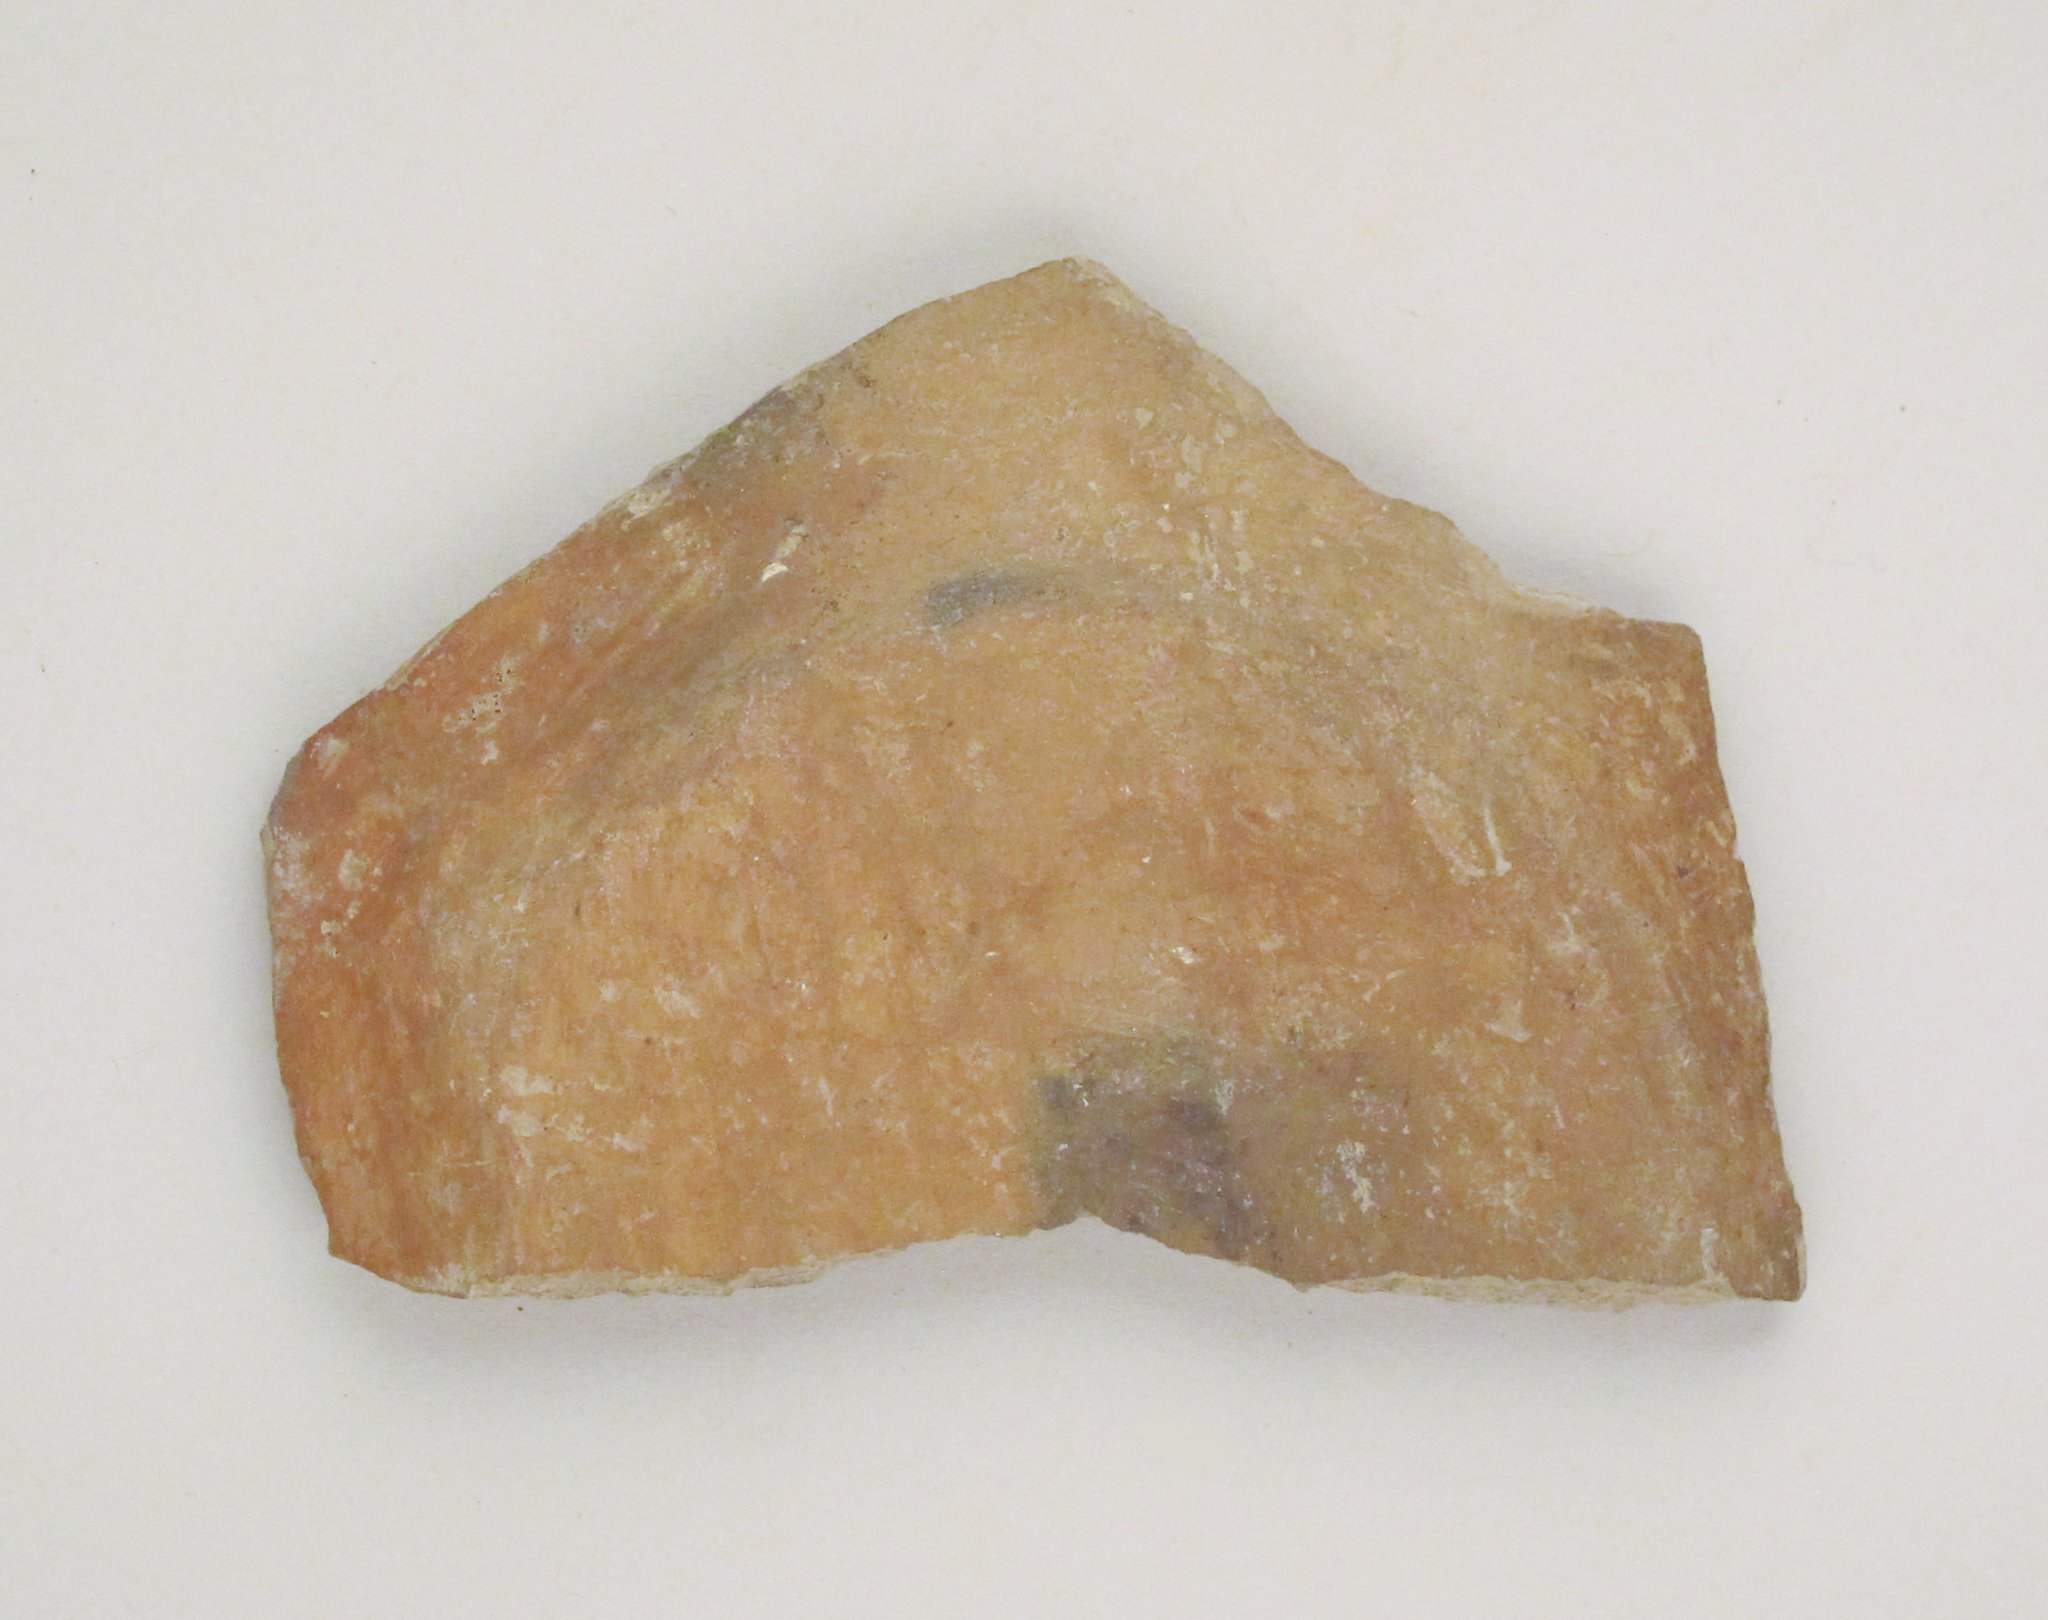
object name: vase fragment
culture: aegean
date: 2000-1550 BCE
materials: terracotta